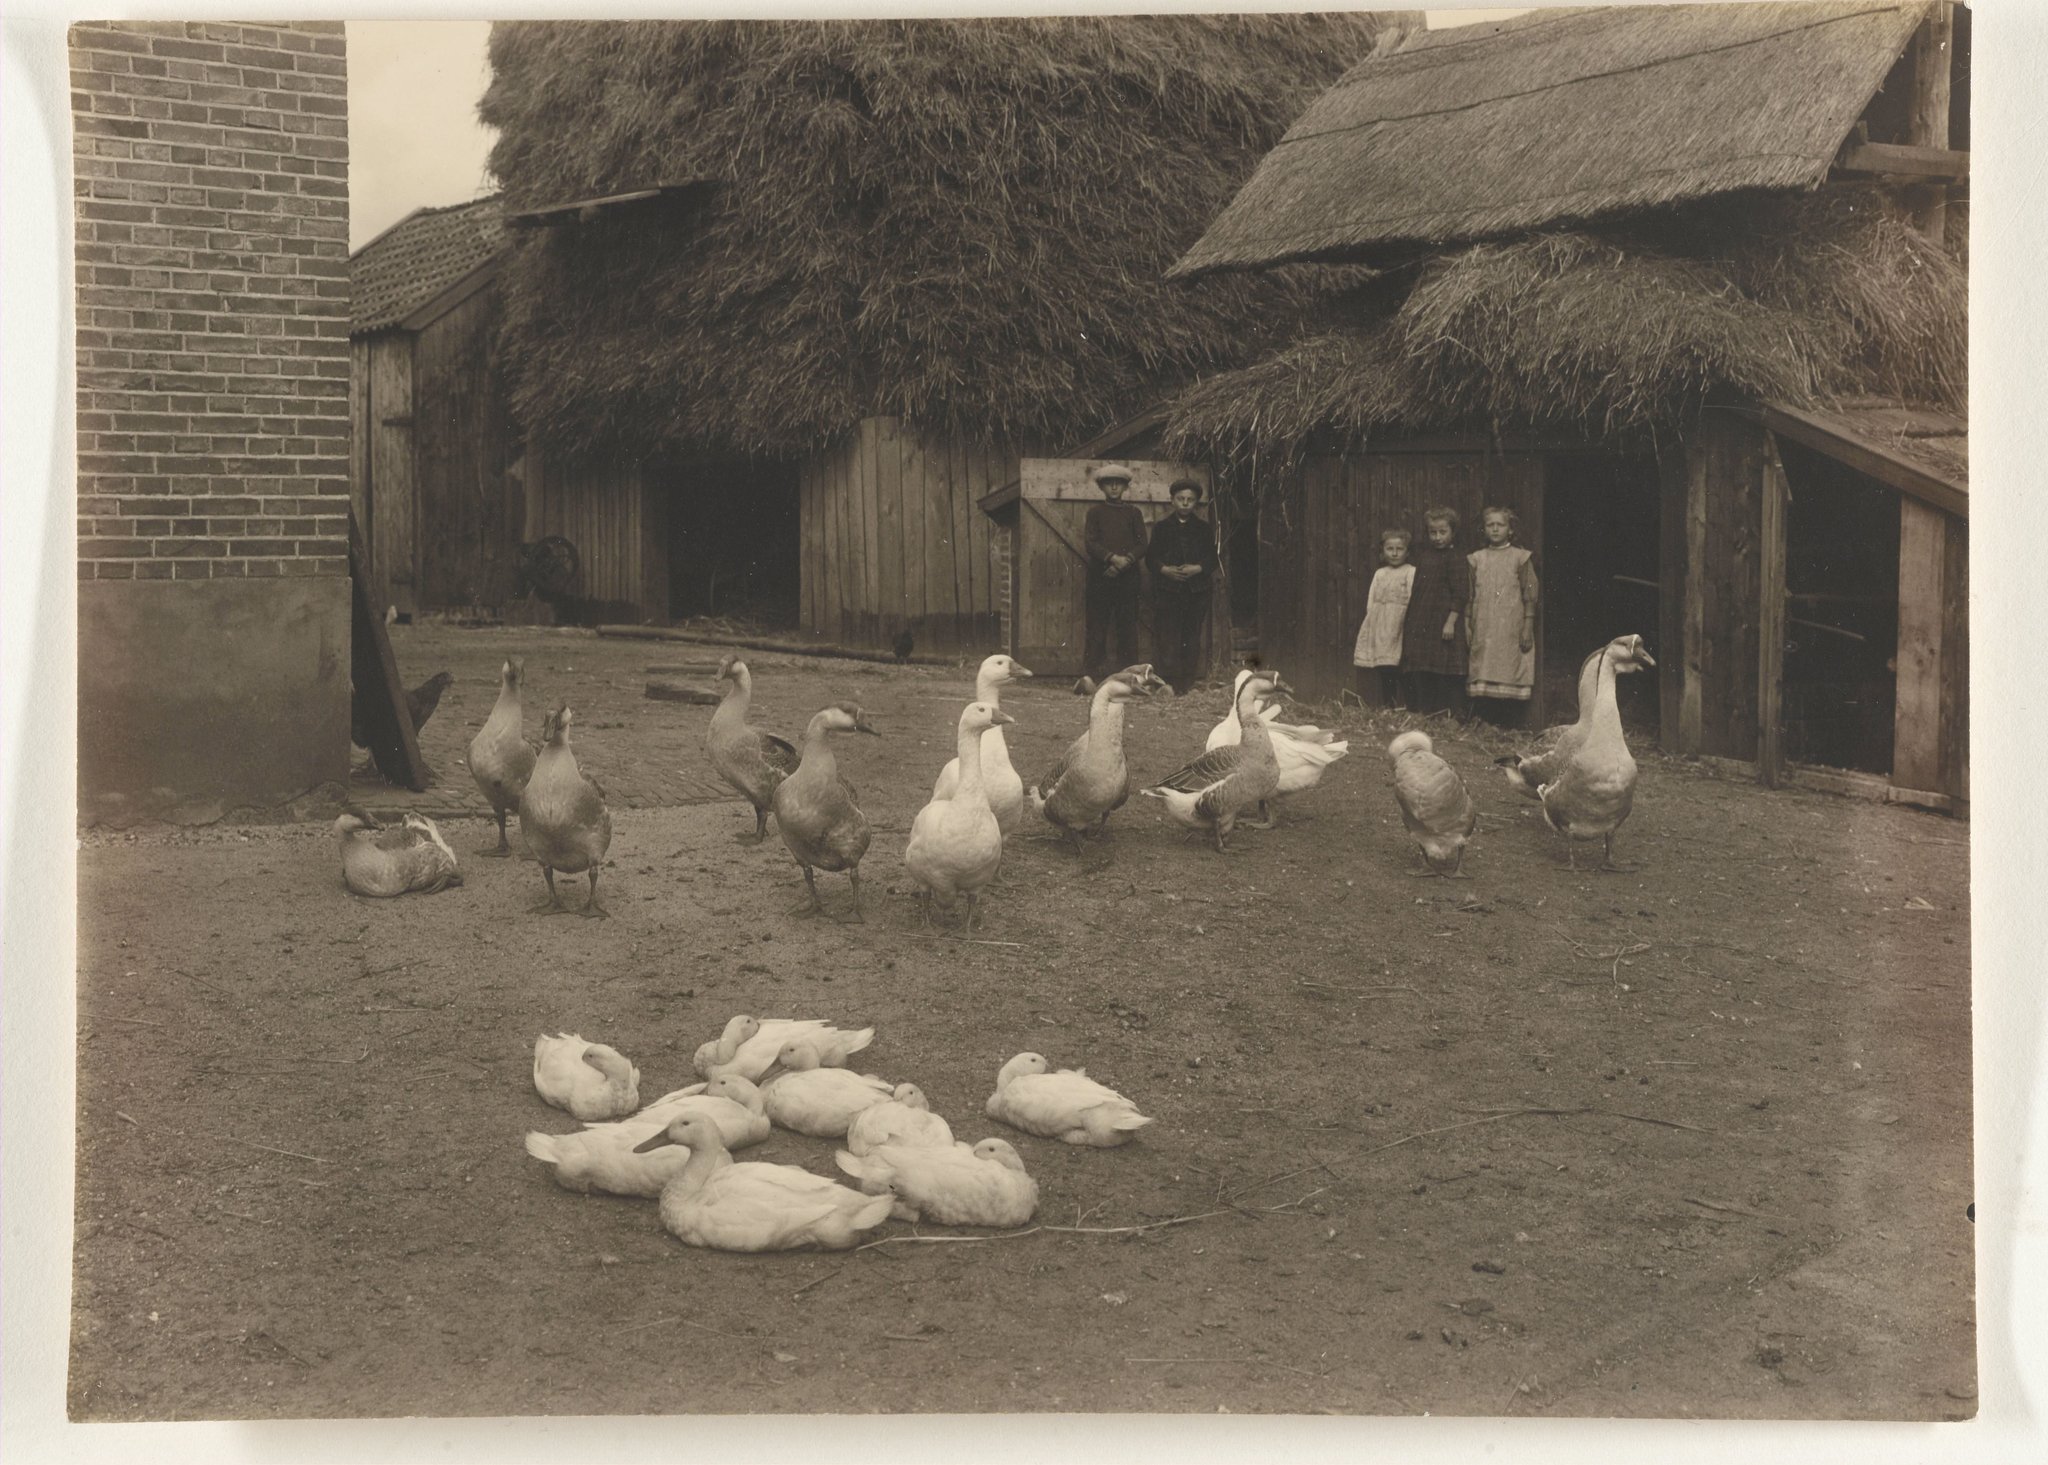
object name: photograph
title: Kinder Gänse und Enten bij eenen Bauernhof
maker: richard tepe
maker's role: fotograaf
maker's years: 1864-1952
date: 1900-1930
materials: paper, cardboard, photographic support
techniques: gelatin silver print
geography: netherlands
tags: farm or solitary house in landscape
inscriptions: annotation: ‘Kinder Gänse und Enten / bij eenen Bauernhof’, signature: ‘foto / R Tepe’